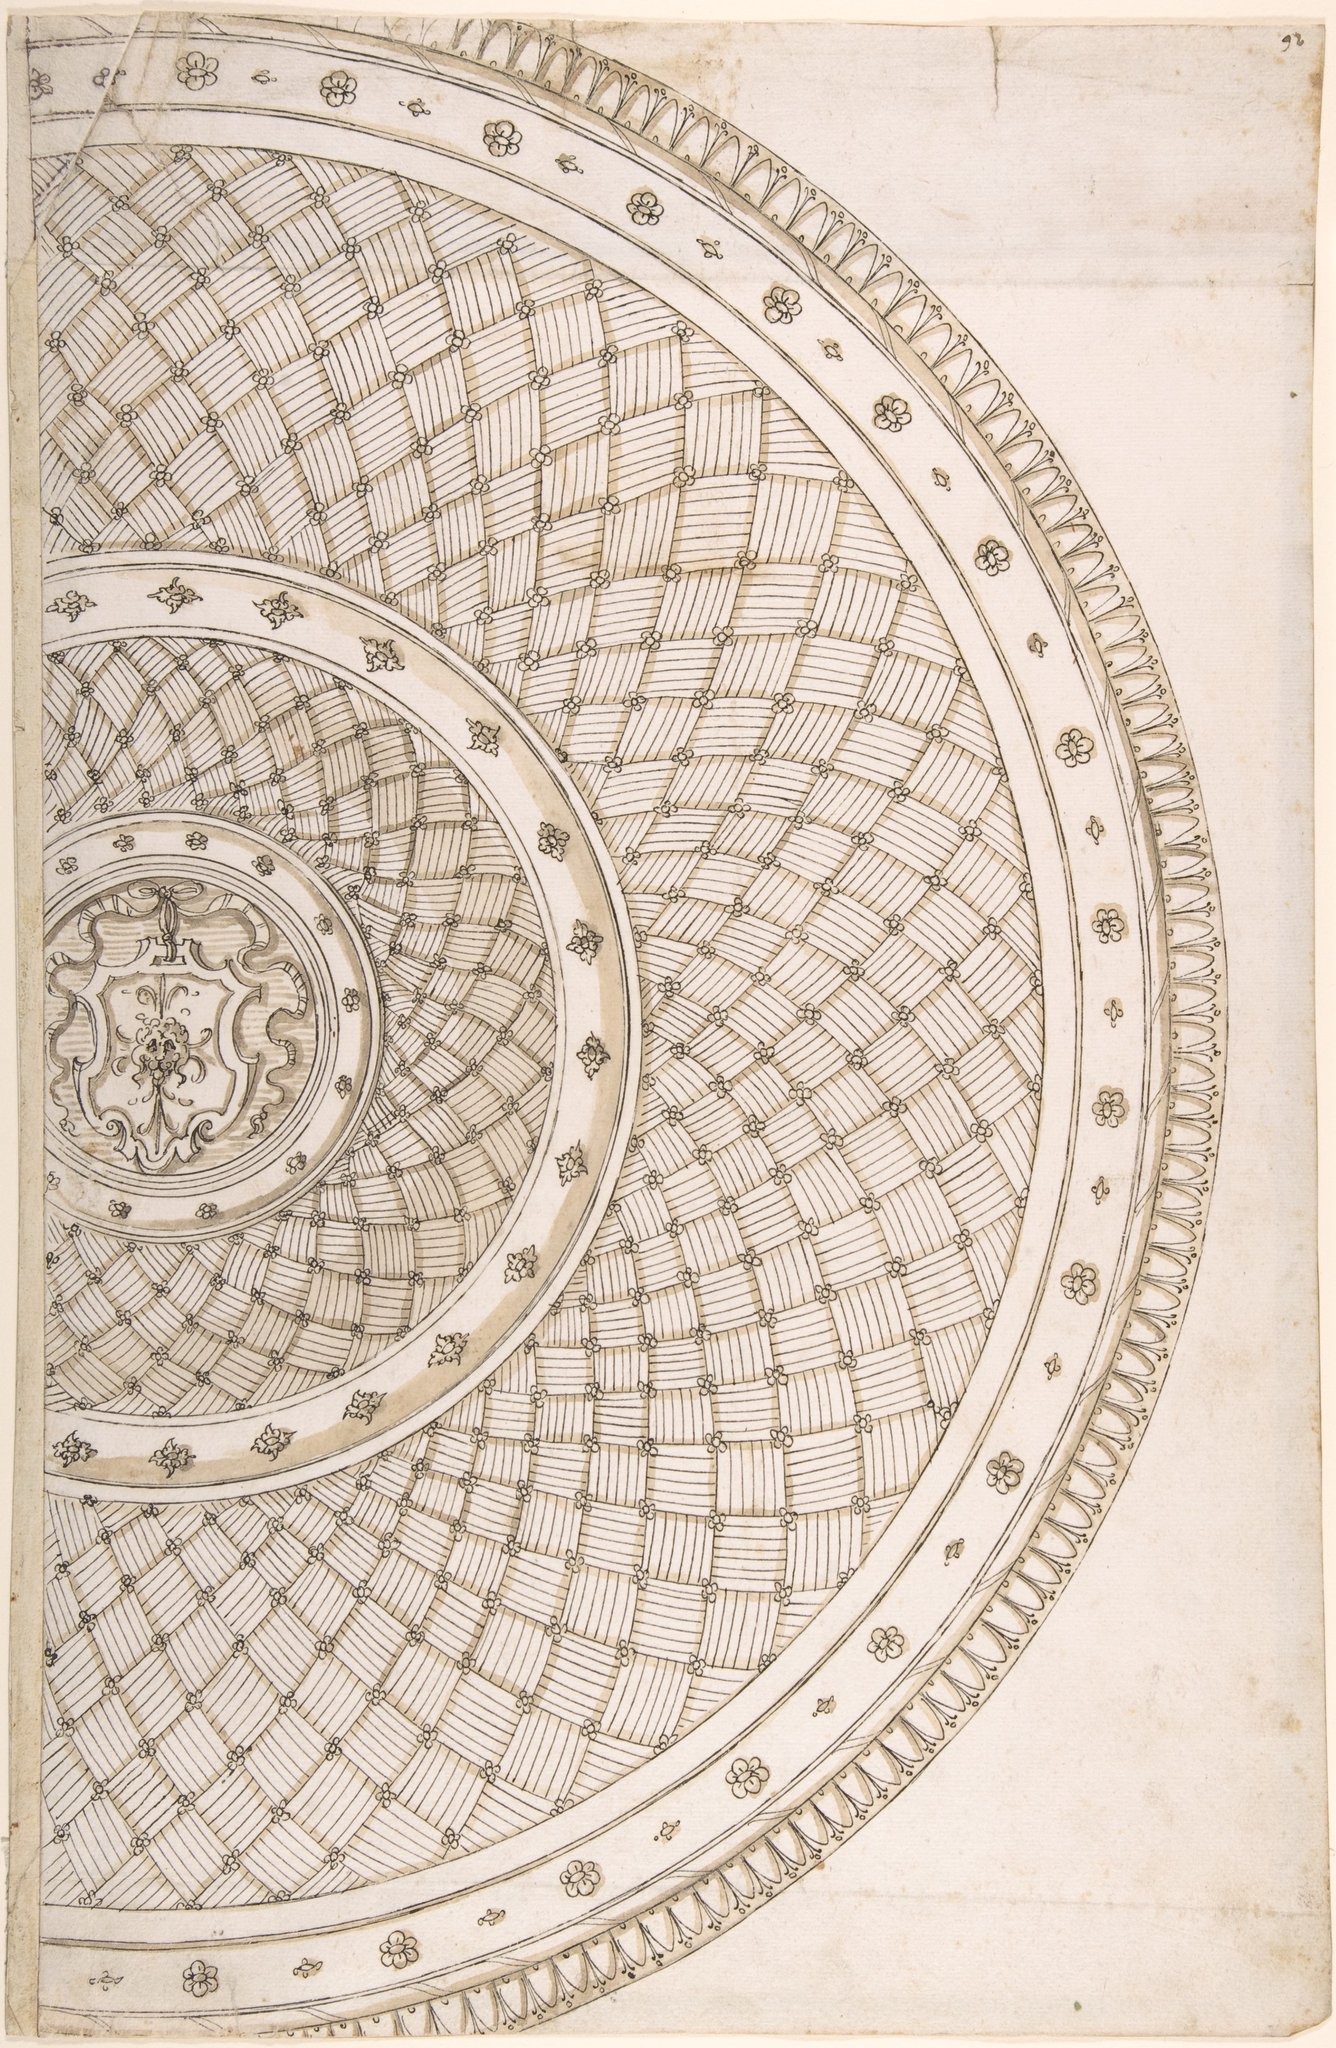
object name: drawing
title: Design for a platter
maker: erasmus hornick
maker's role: artist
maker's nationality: netherlandish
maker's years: 1501-1583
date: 1501-1600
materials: ink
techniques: brush, pen, wash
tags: dishes